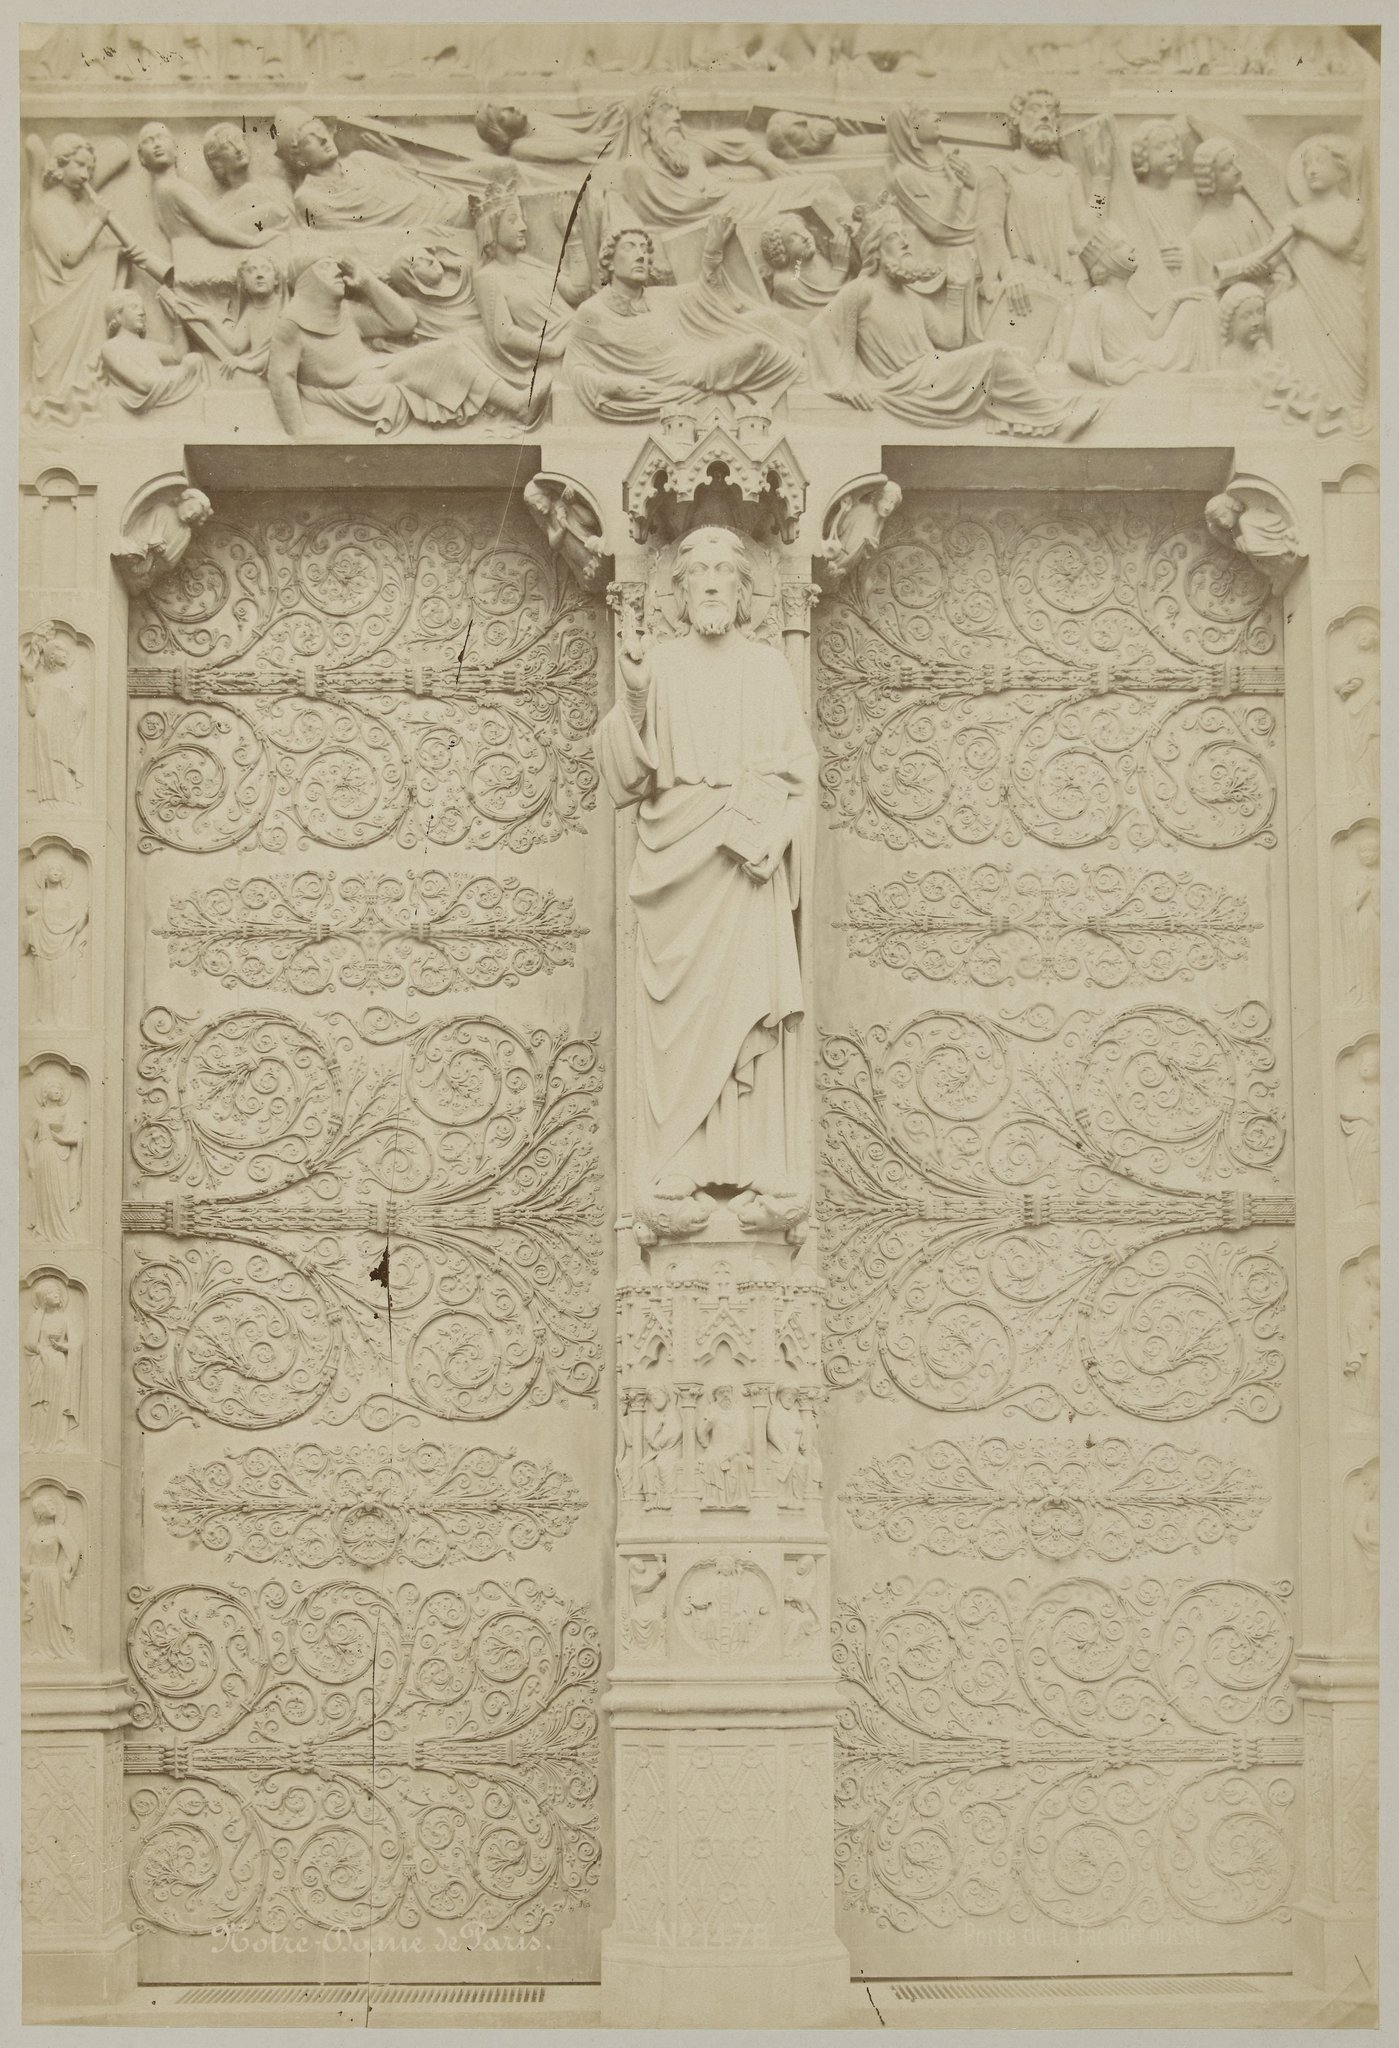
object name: photograph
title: Westportaal van de Notre-Dame te Parijs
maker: paul robert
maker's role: fotograaf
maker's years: 1865-1905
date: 1890-1900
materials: cardboard, paper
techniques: albumen print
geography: paris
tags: parts of church exterior and annexes: portal, piece of sculpture, reproduction of a piece of sculpture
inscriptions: number: ‘No. 1478’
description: De foto is afgedrukt met een gebroken glasnagatief.